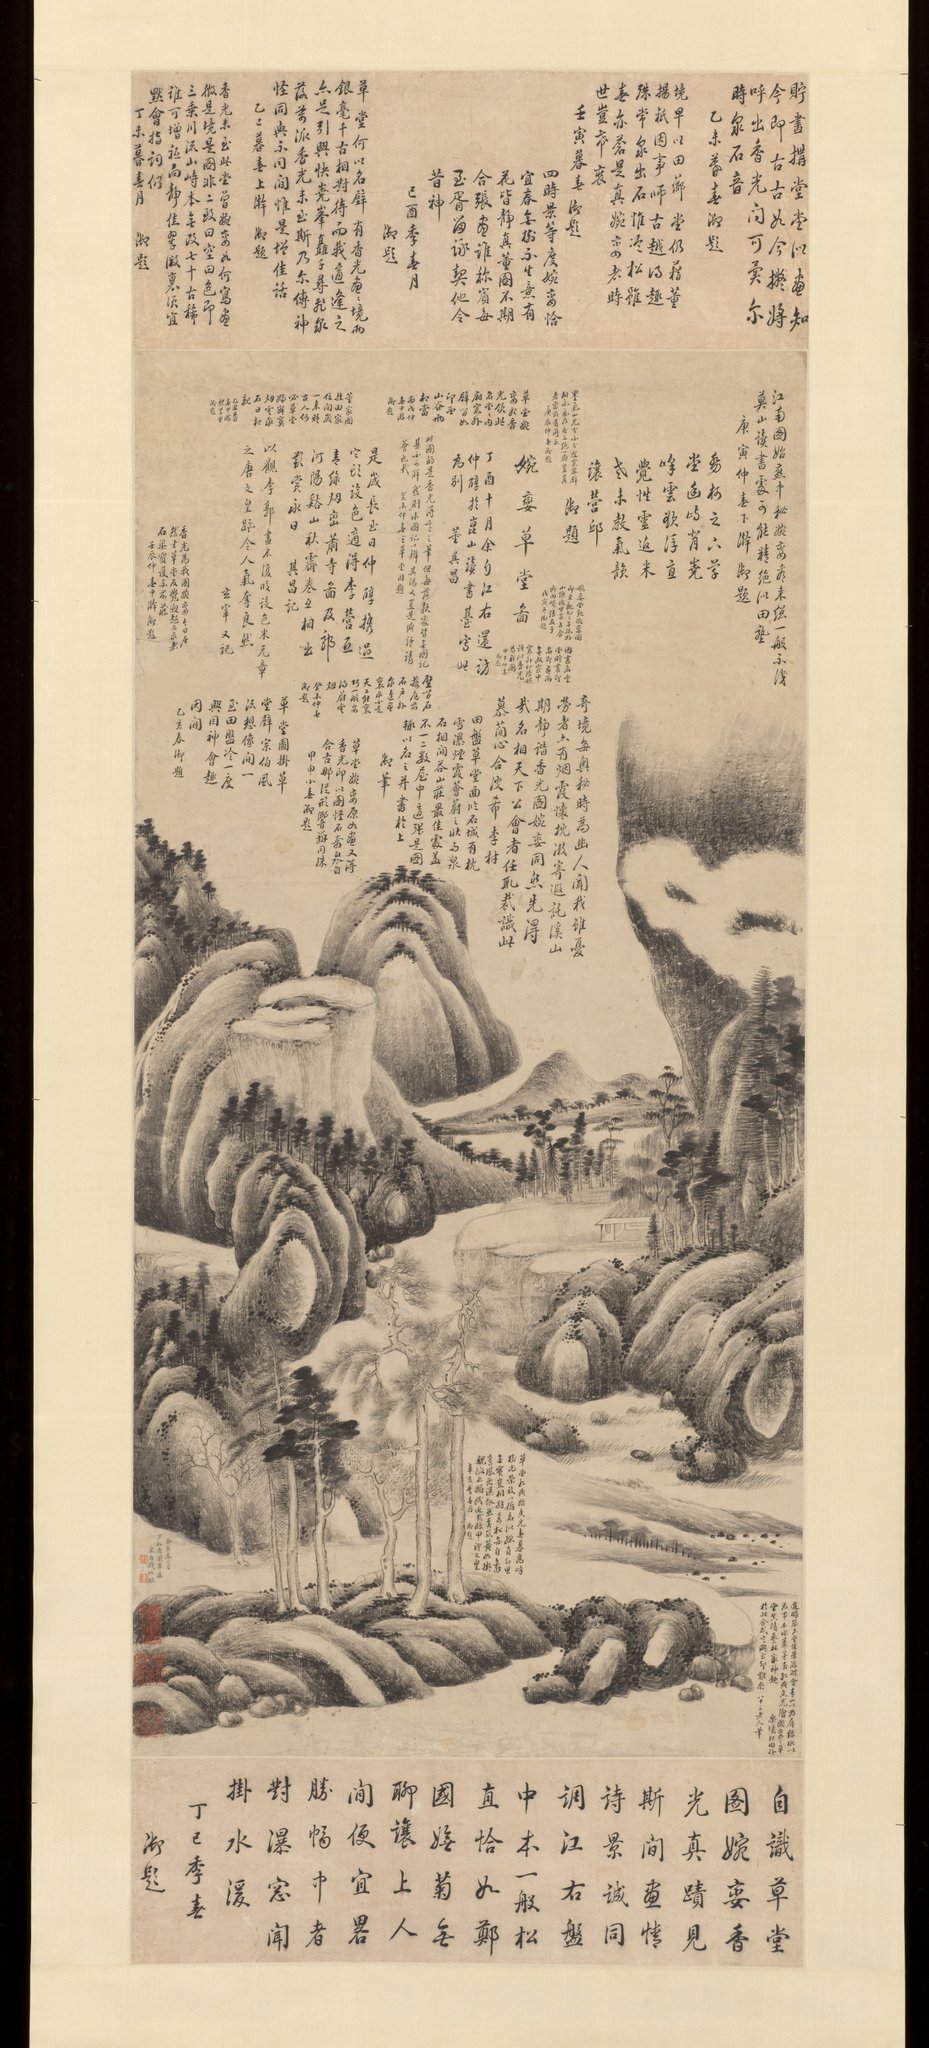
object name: hanging scroll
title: Copy of Dong Qichang’s Wanluan Thatched Cottage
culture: chinese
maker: qian du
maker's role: artist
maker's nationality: chinese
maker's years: 1763-1844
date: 1803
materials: ink, paper